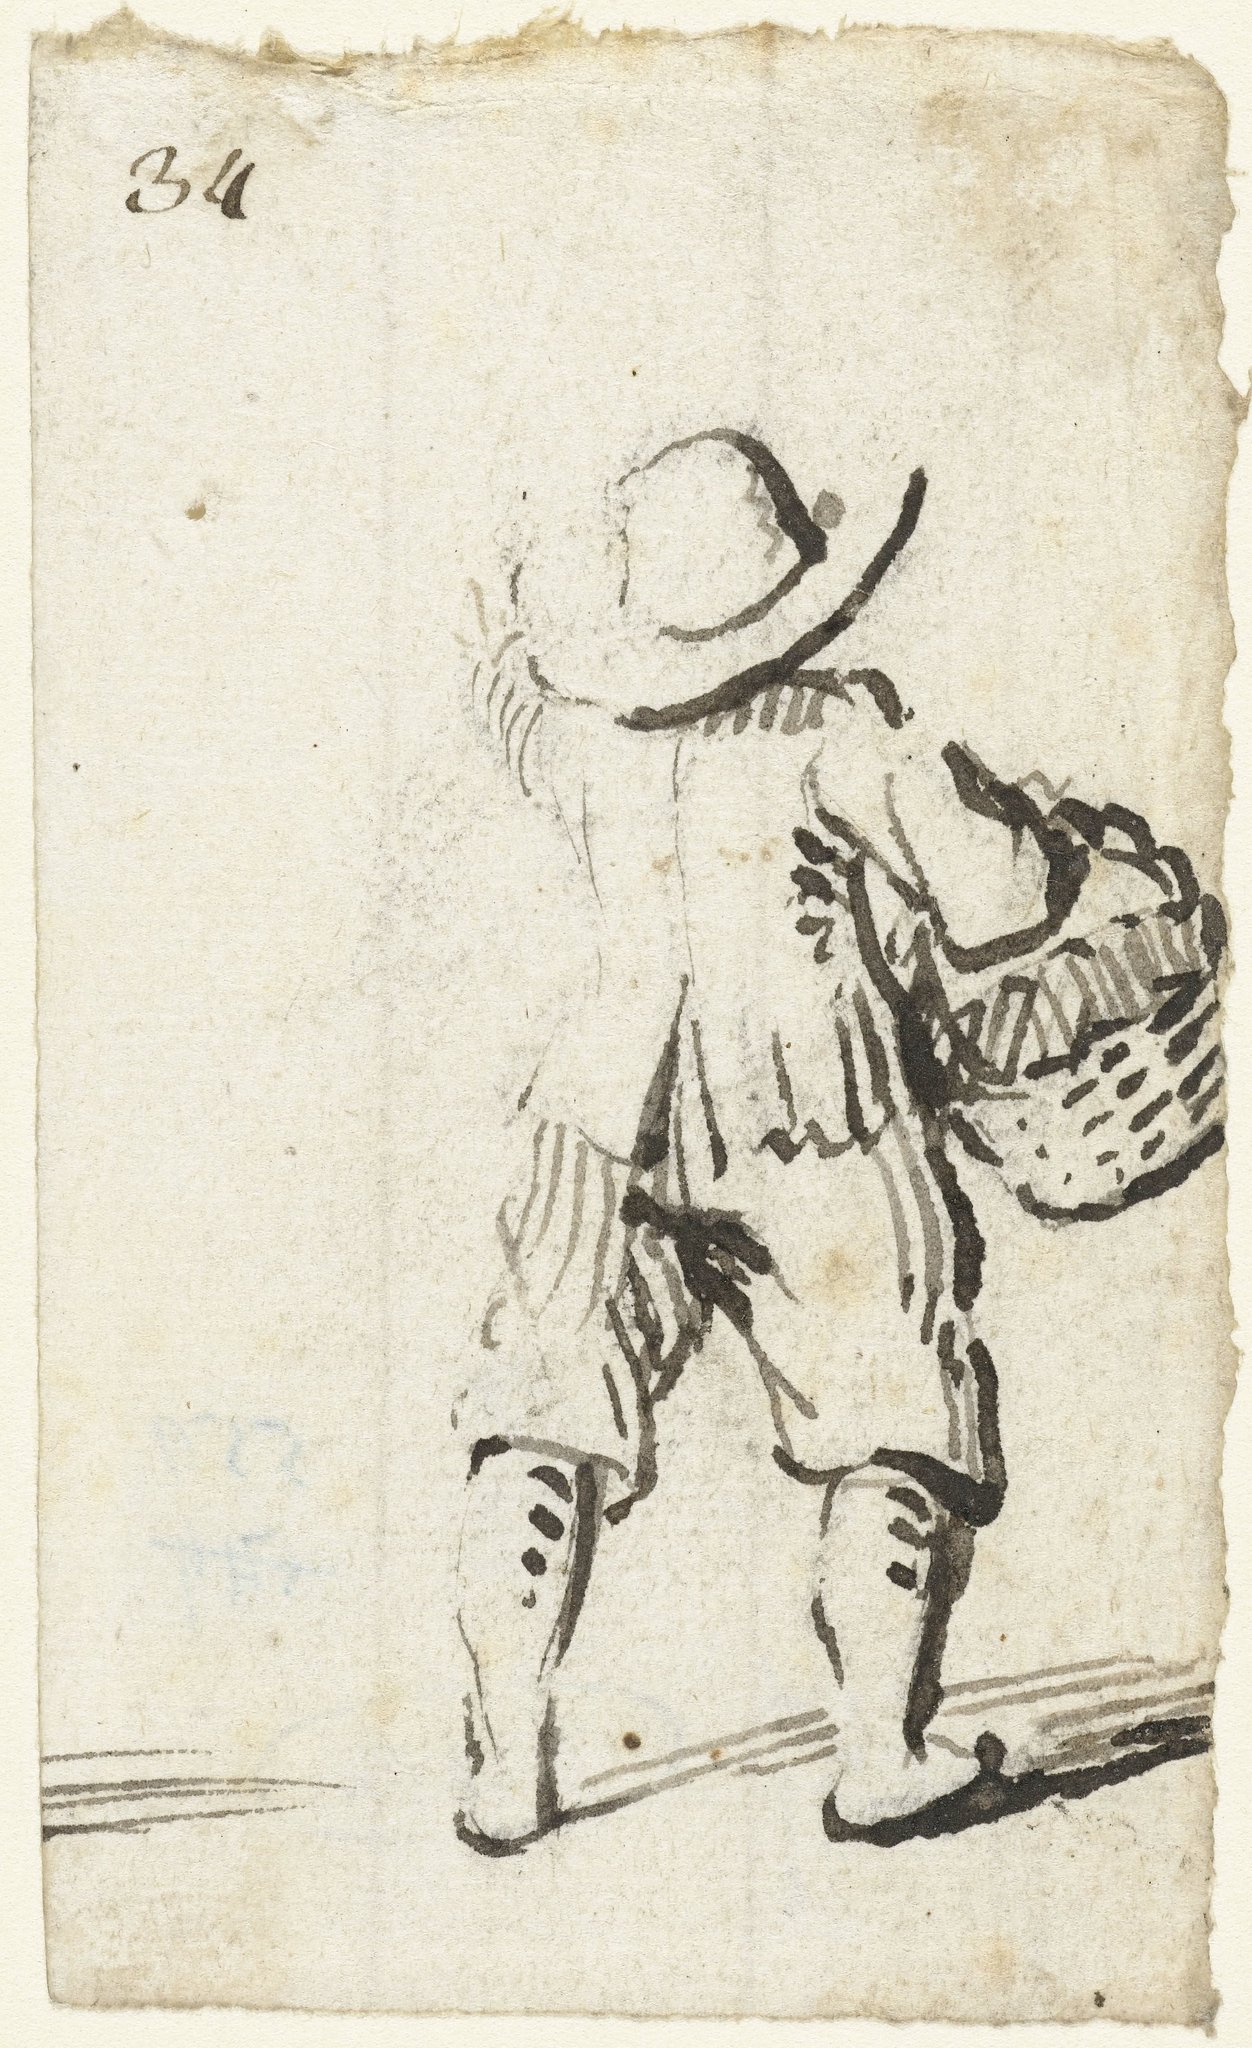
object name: drawing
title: Jongen met een mand aan zijn arm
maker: harmen ter borch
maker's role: draughtsman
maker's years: 1638-1677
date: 1649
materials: chalk, ink, paper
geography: zwolle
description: Jongen met een mand aan zijn rechterarm, de andere arm houdt hij omhoog.